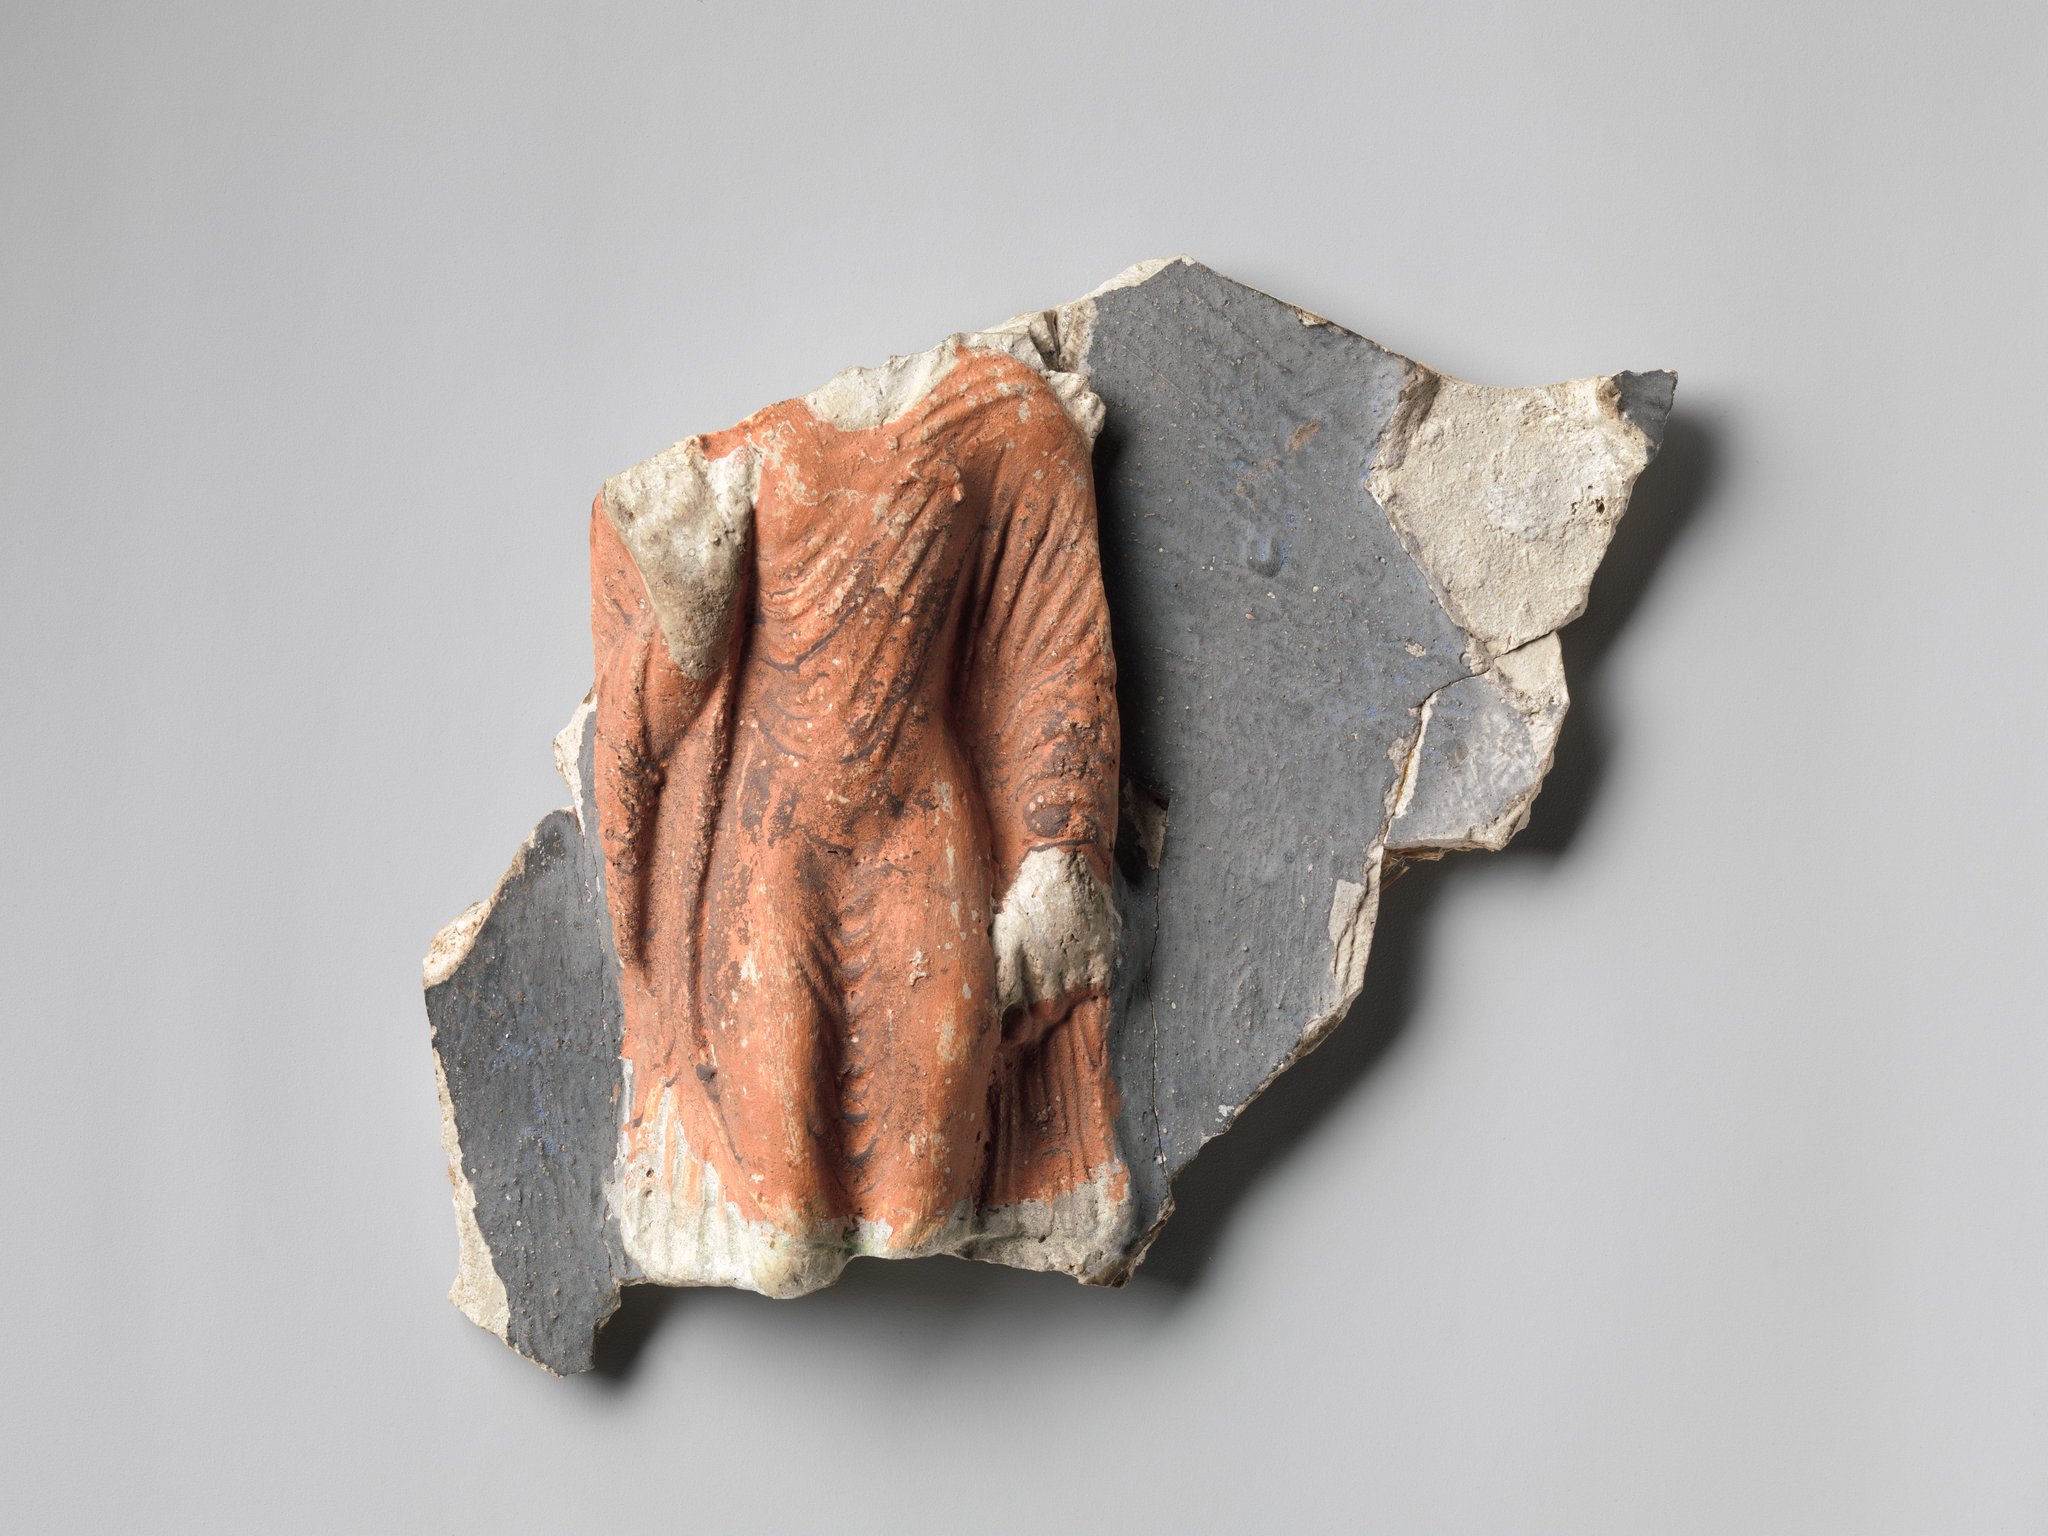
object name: relief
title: Fragment of a Halo with Buddha Figure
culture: chinese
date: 501-700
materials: plaster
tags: buddhism,buddha